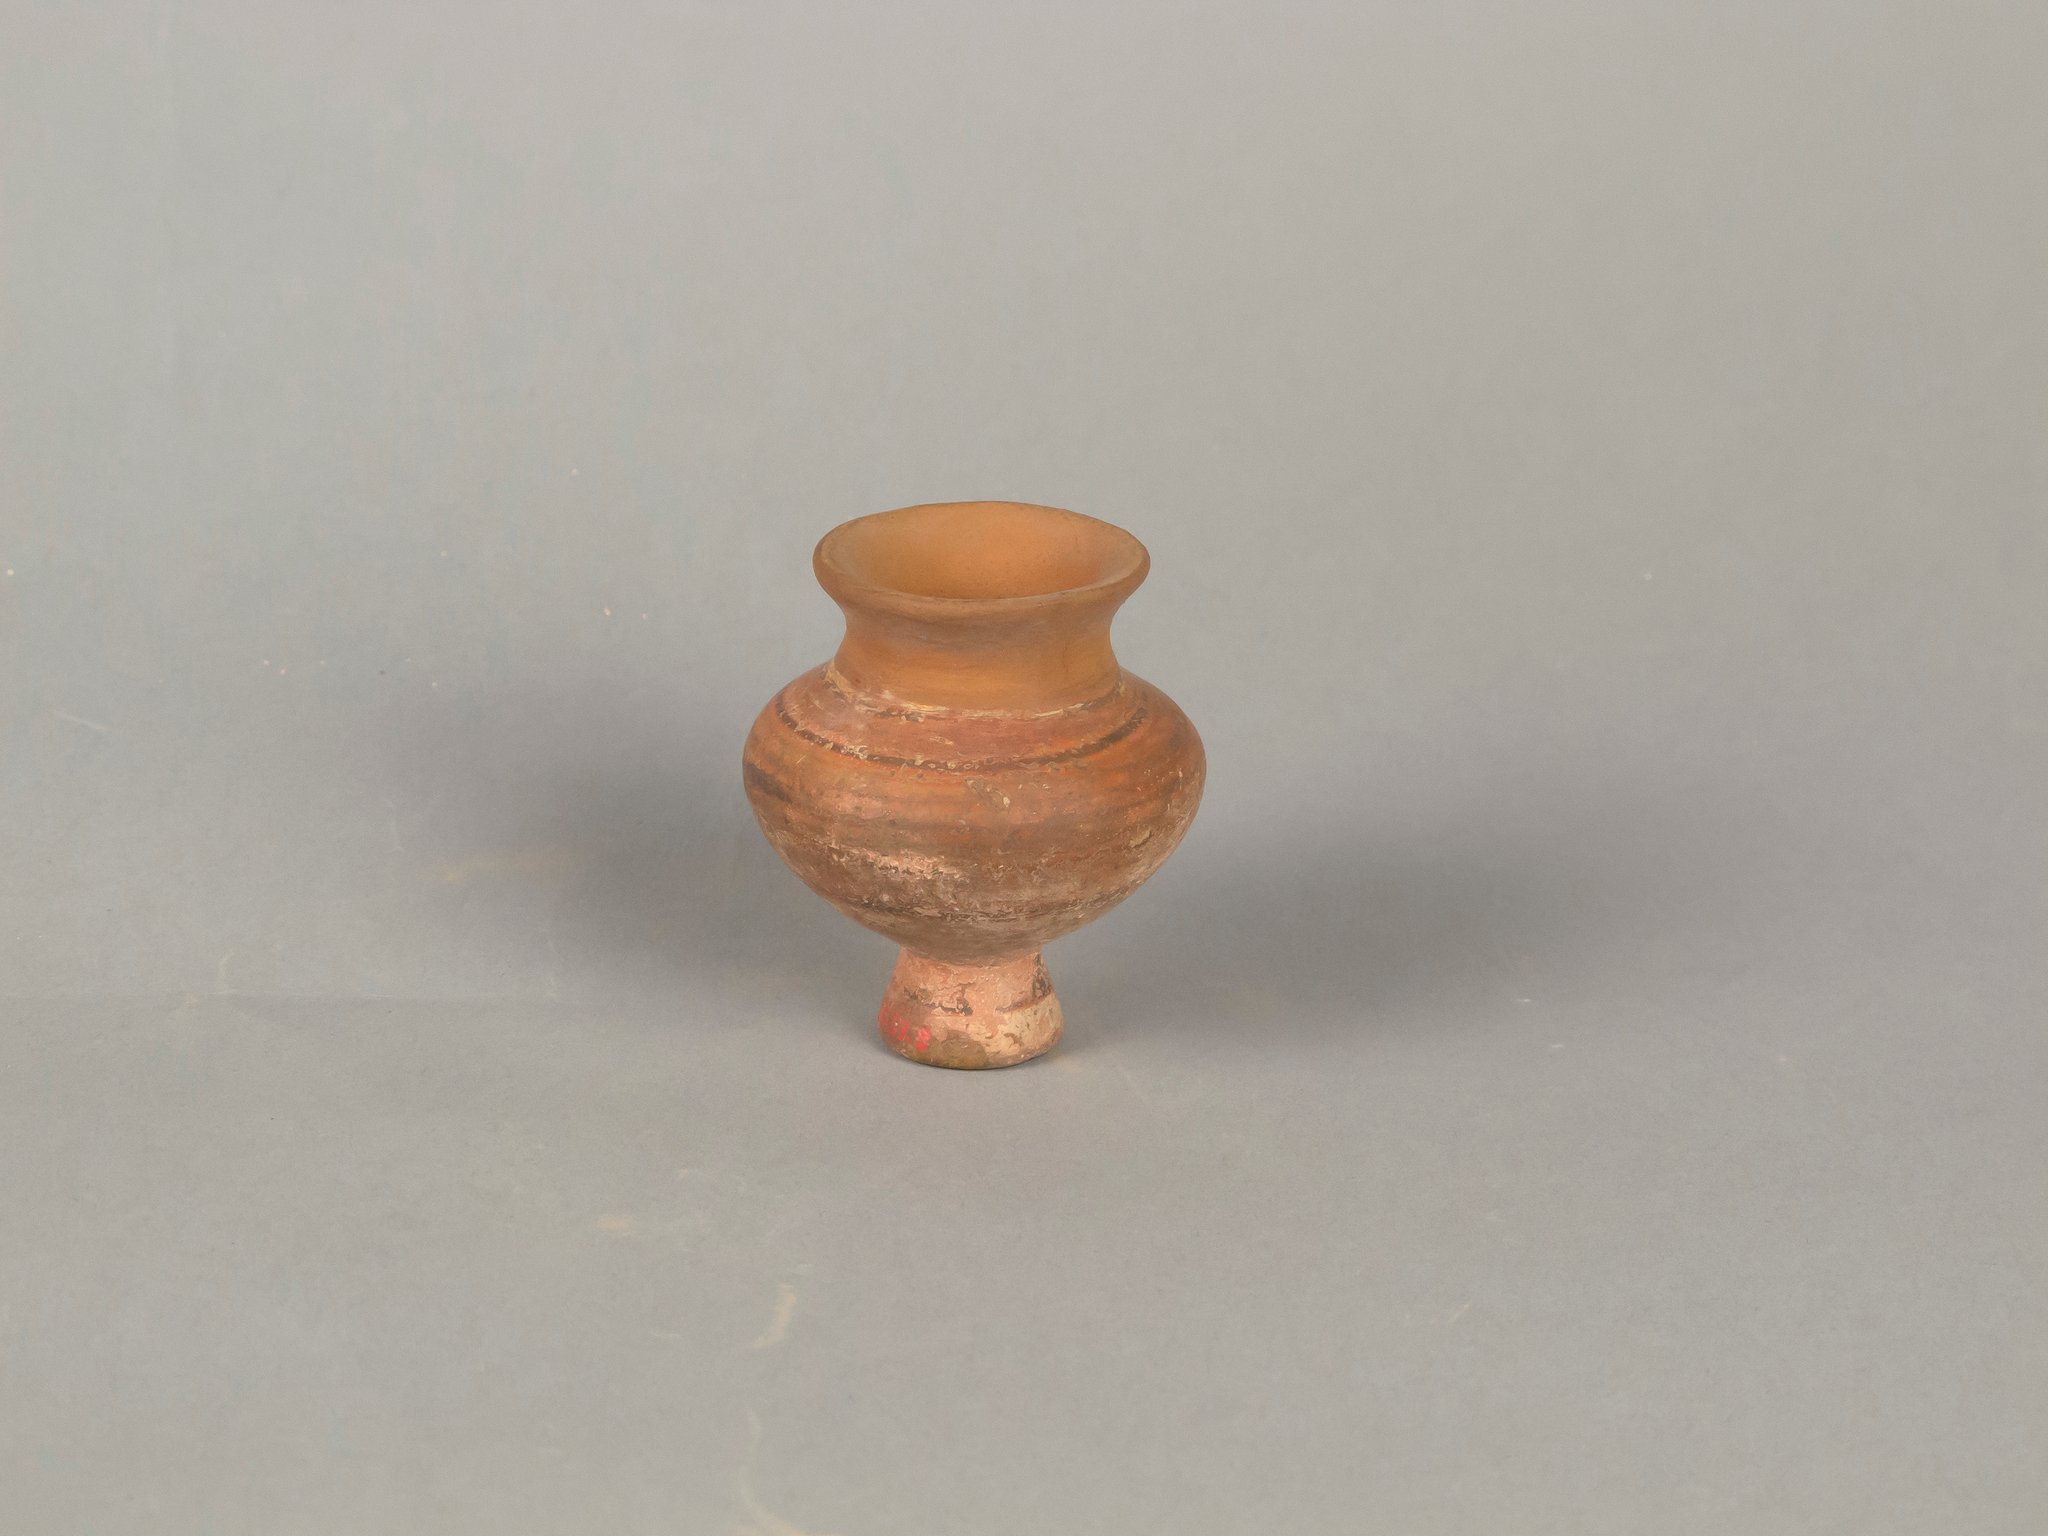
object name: vase, miniature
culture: greek or lydian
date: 900-30 BCE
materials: terracotta